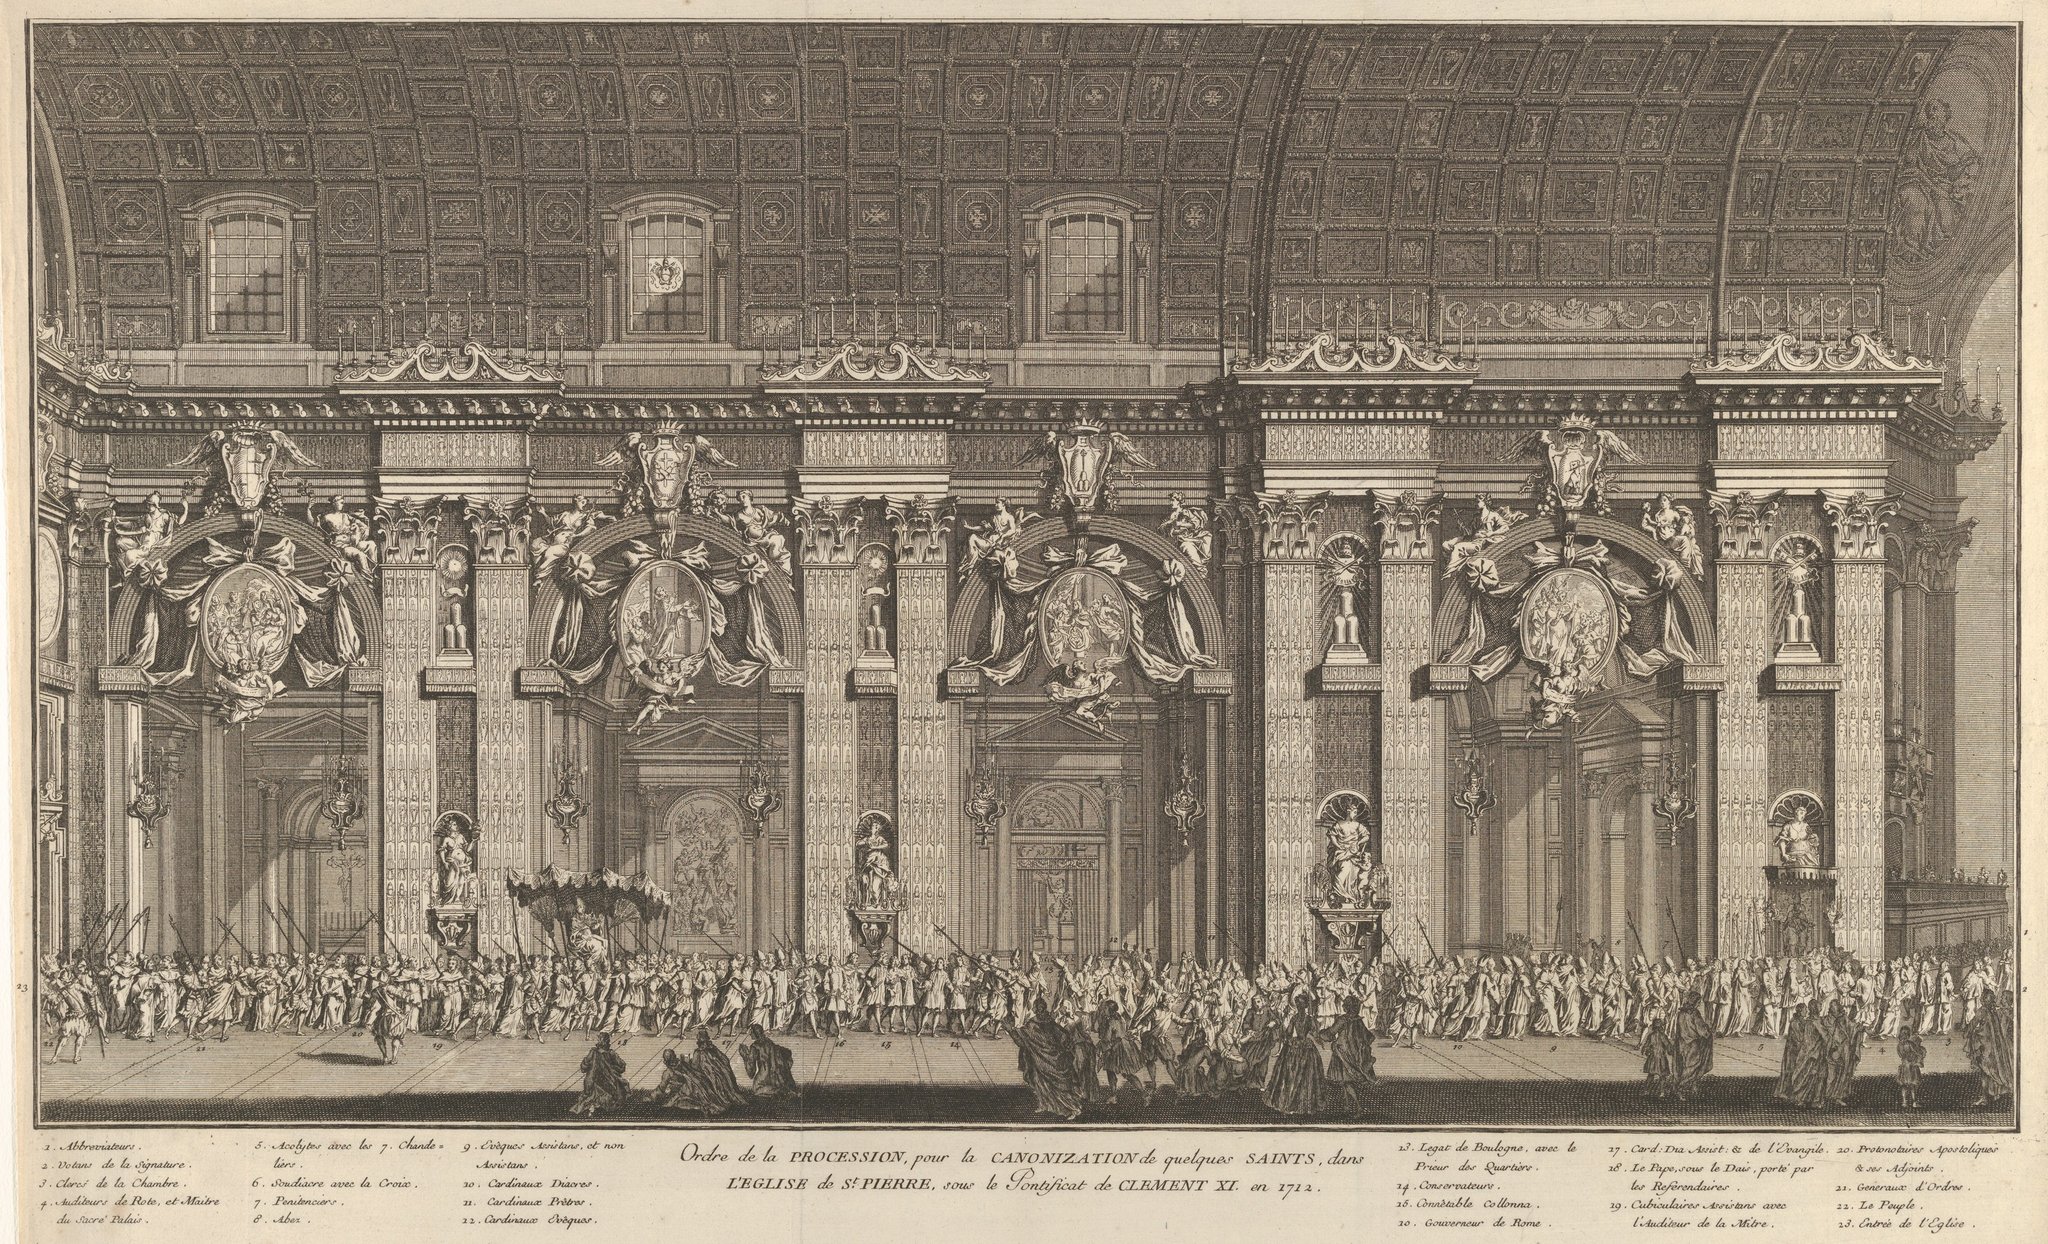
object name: print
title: Procession held in Saint Peter's Basilica in honor of the Canonization of several Saints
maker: anonymous, french, 18th century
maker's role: artist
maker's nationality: french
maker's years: 1700-1800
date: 1712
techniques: engraving, etching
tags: men,women,saint peter,crowd